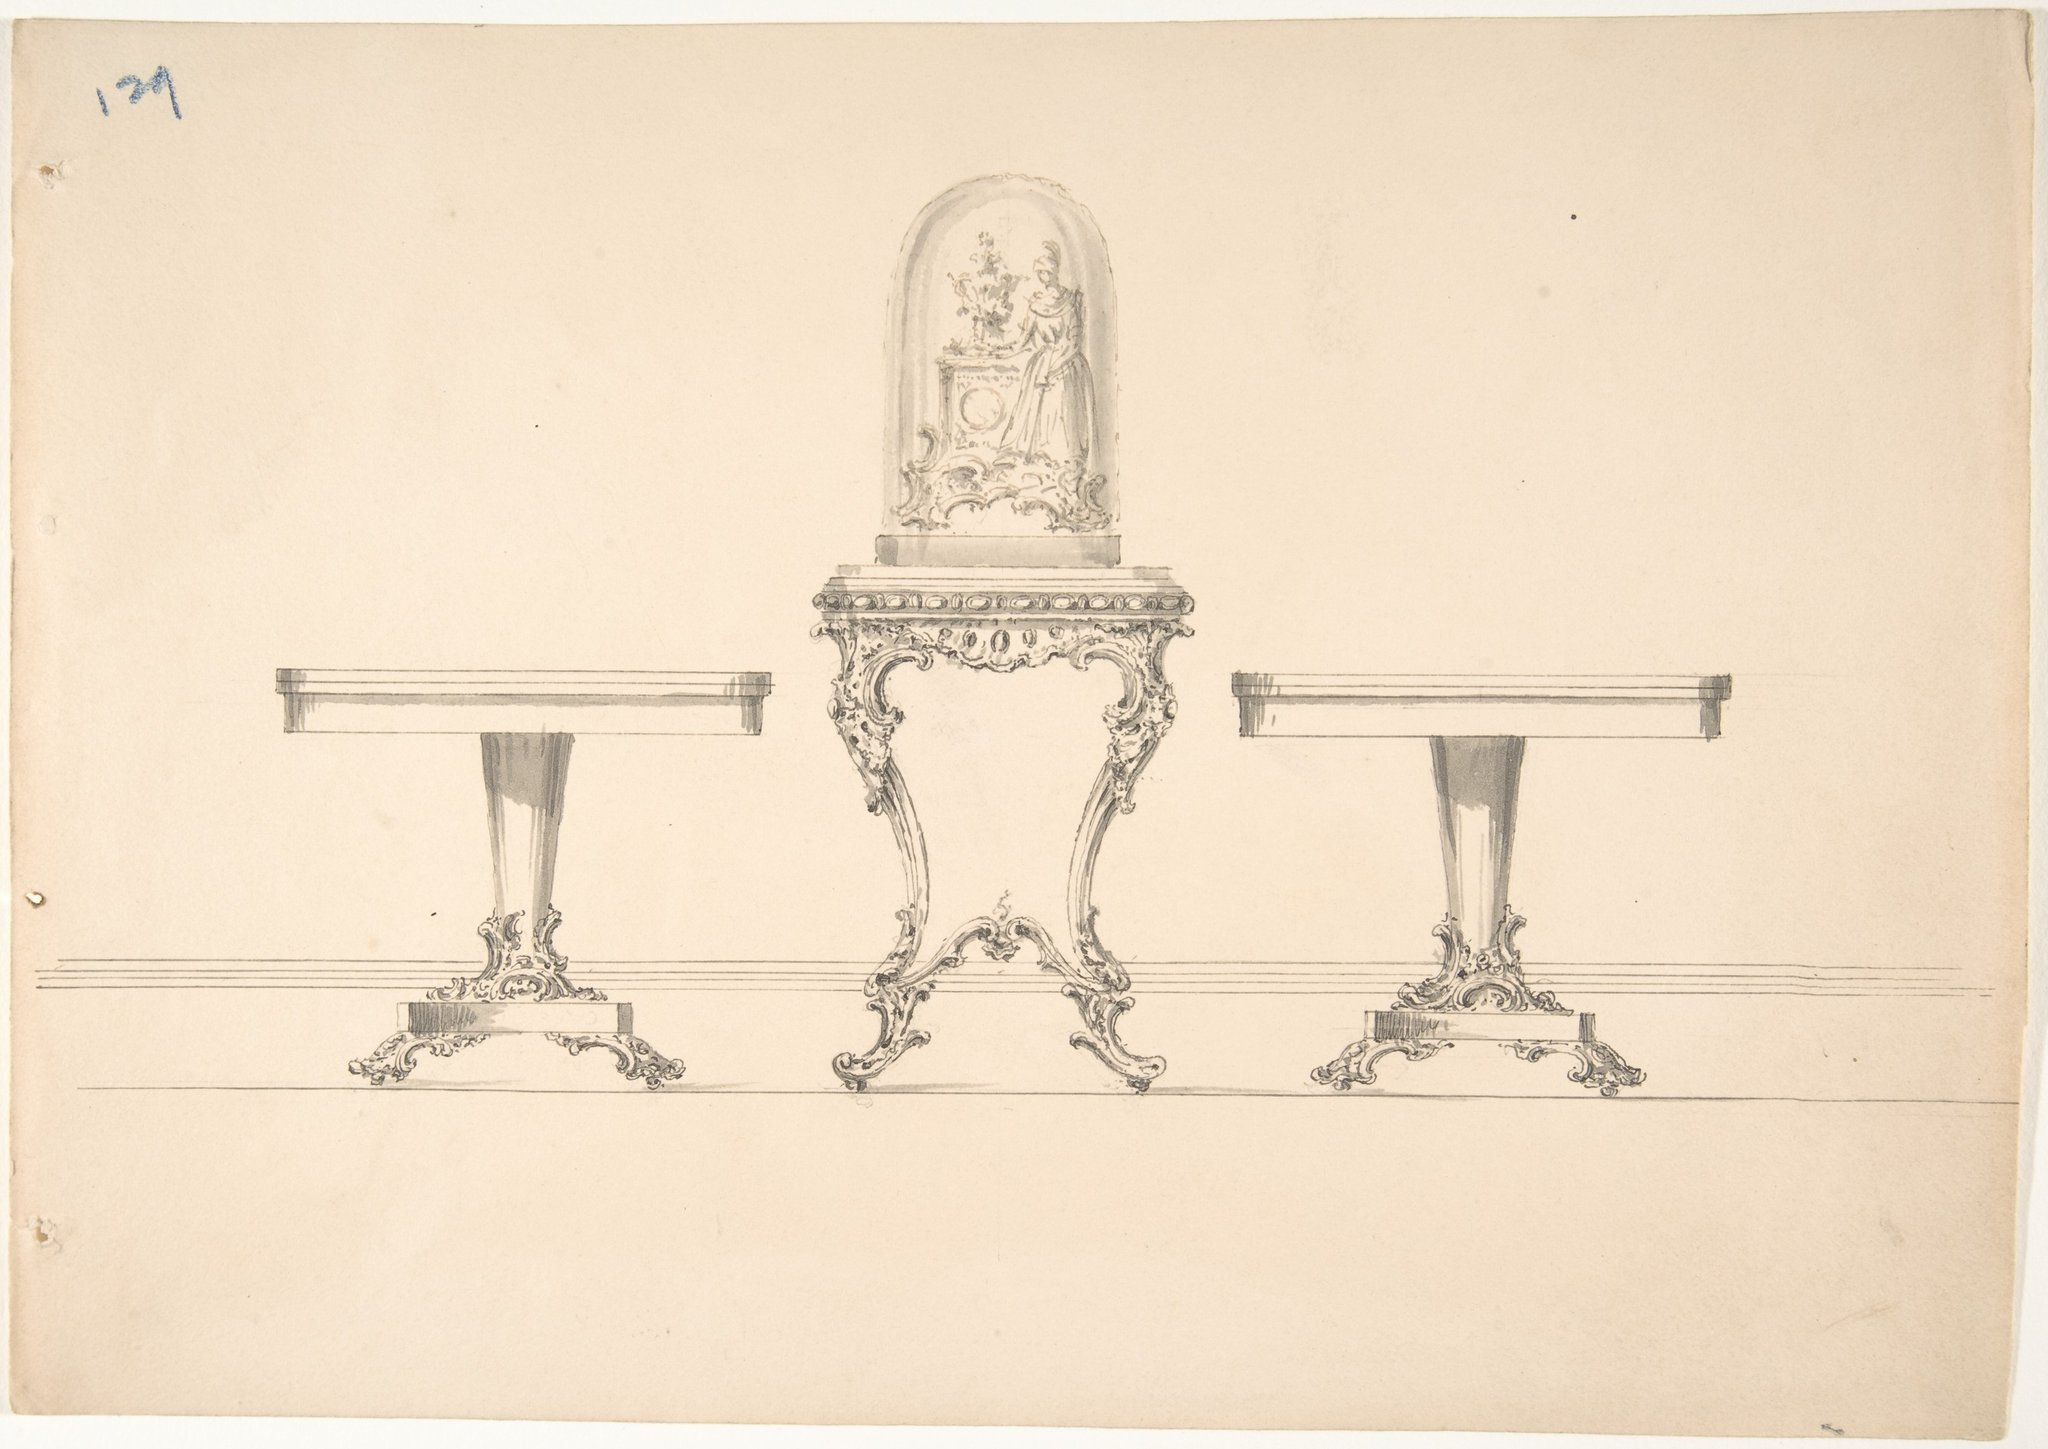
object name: drawing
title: Design for Two Round Pedestal Tables and Square Rococo-style Table Supporting a Clock under Glass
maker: anonymous, british, 19th century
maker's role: artist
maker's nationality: british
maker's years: 1800-1900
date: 1801-1833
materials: ink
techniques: brush, pen, wash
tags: women,tables